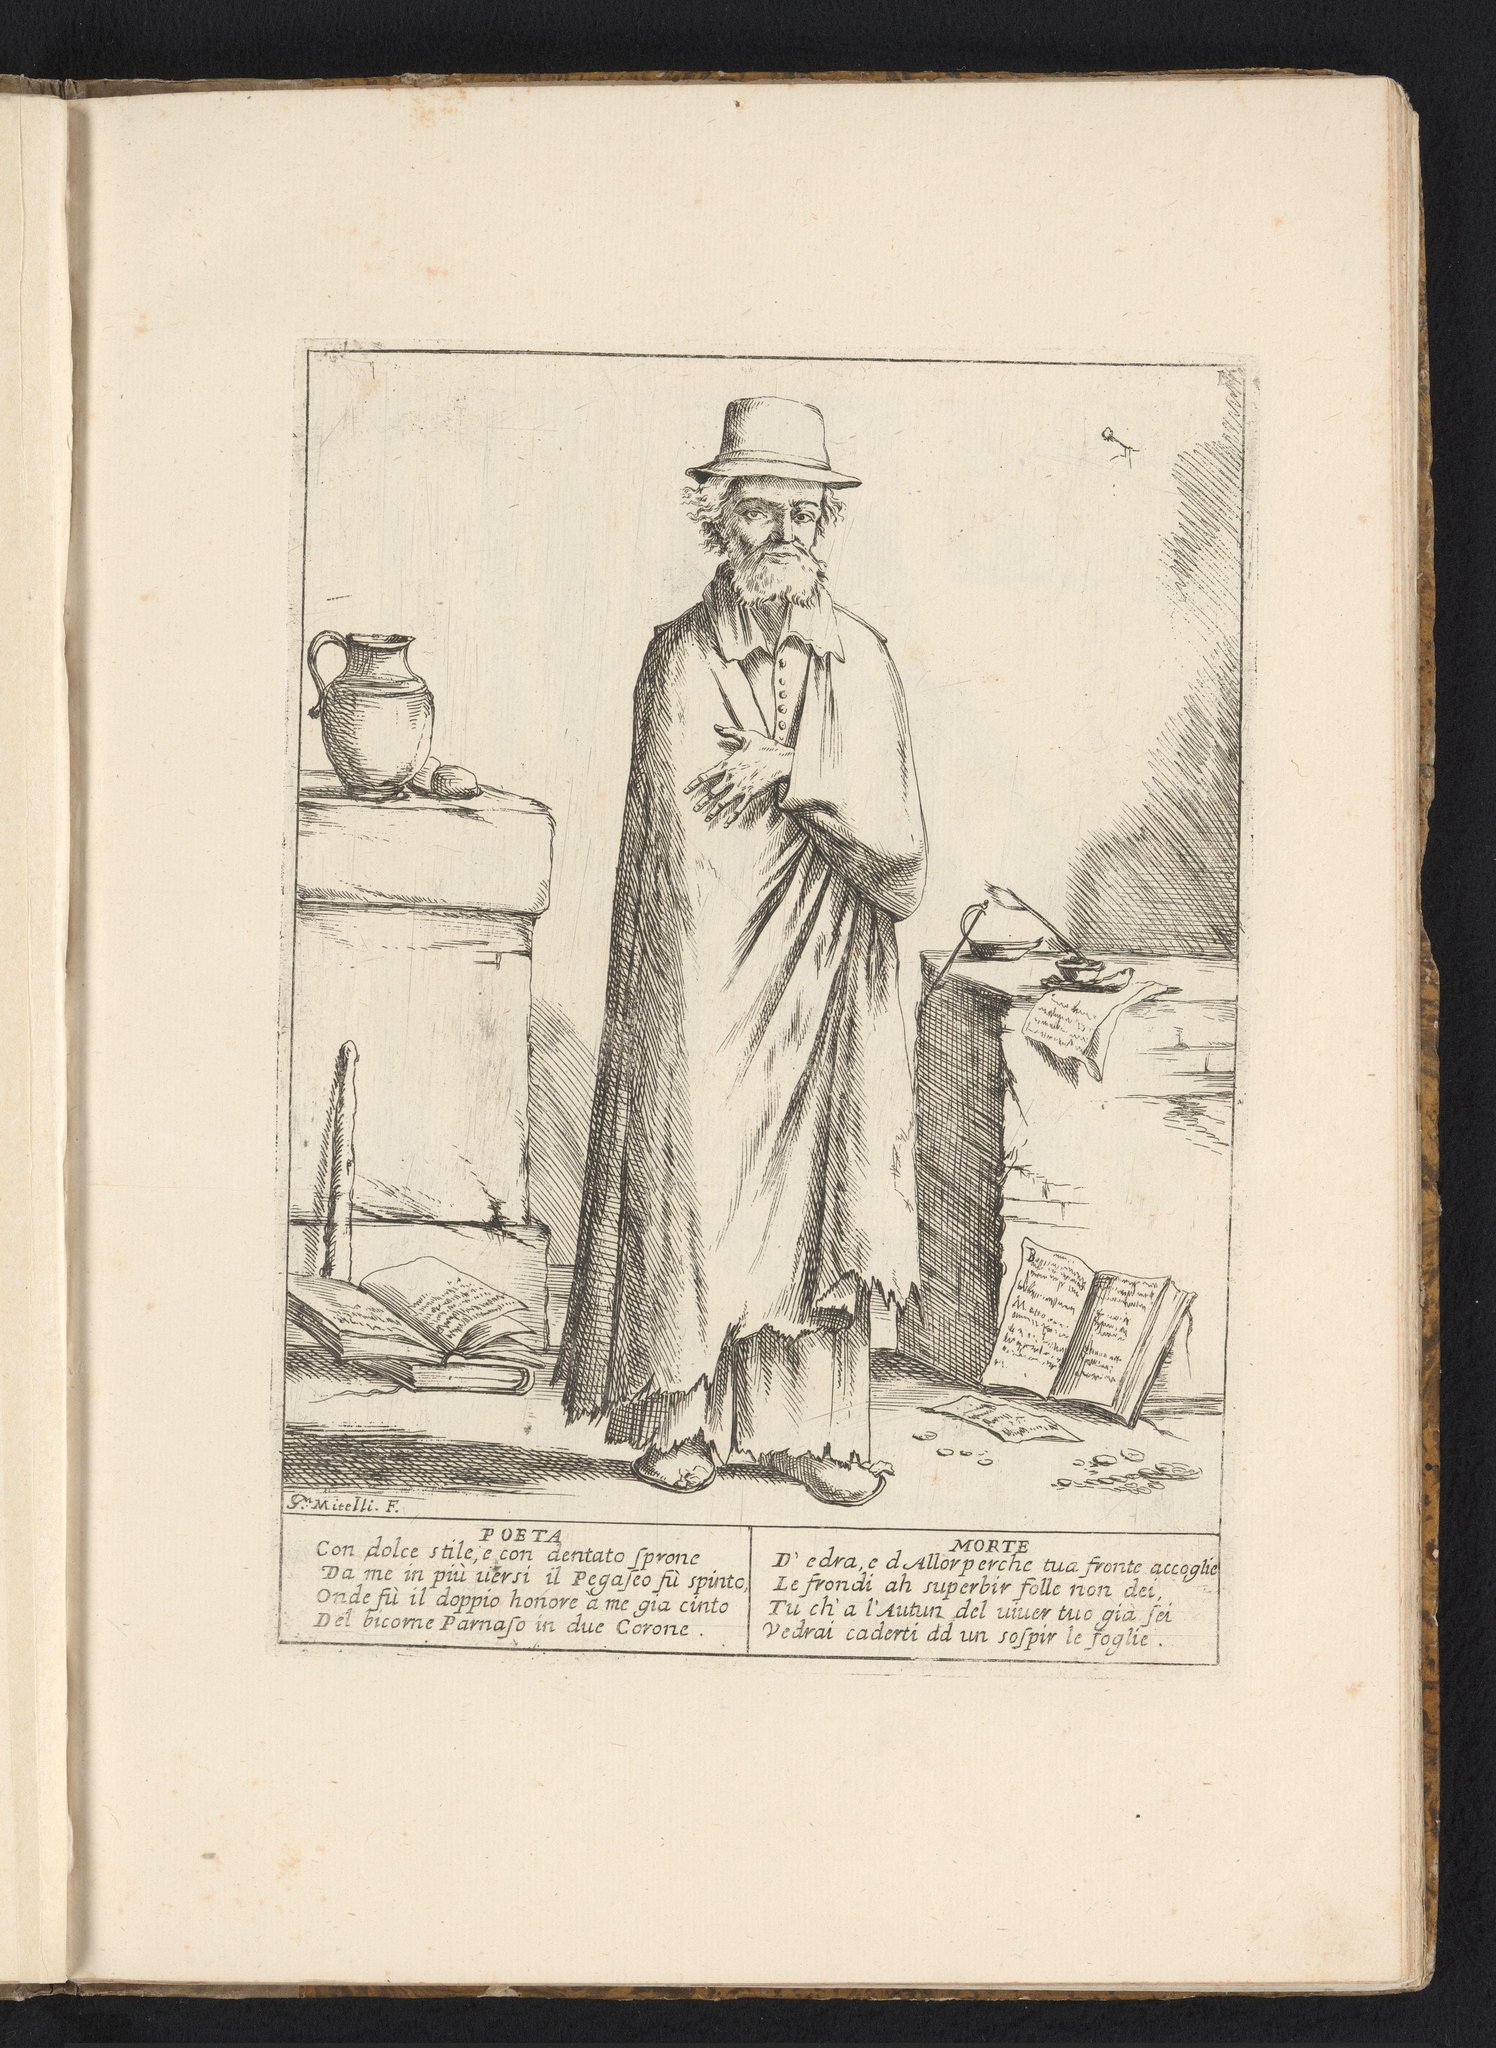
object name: print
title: De dichter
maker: giuseppe maria mitelli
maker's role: draughtsman, painter, print maker, publisher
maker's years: 1634-1718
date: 1675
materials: paper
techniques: engraving, etching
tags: scenes symbolizing 'vanitas', the 24 hours of day and night, bard, lyric poet, personifications ~ the life of man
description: De dichter (Poeta). Staande man in lange mantel, op de grond liggen boeken en papier, rechts een inkpot en veer. Met twee vierregelige verzen in het Italiaans. Genummerd rechtsboven: 15. Onderdeel van de serie 'De vierentwintig uren van het menselijk geluk'.